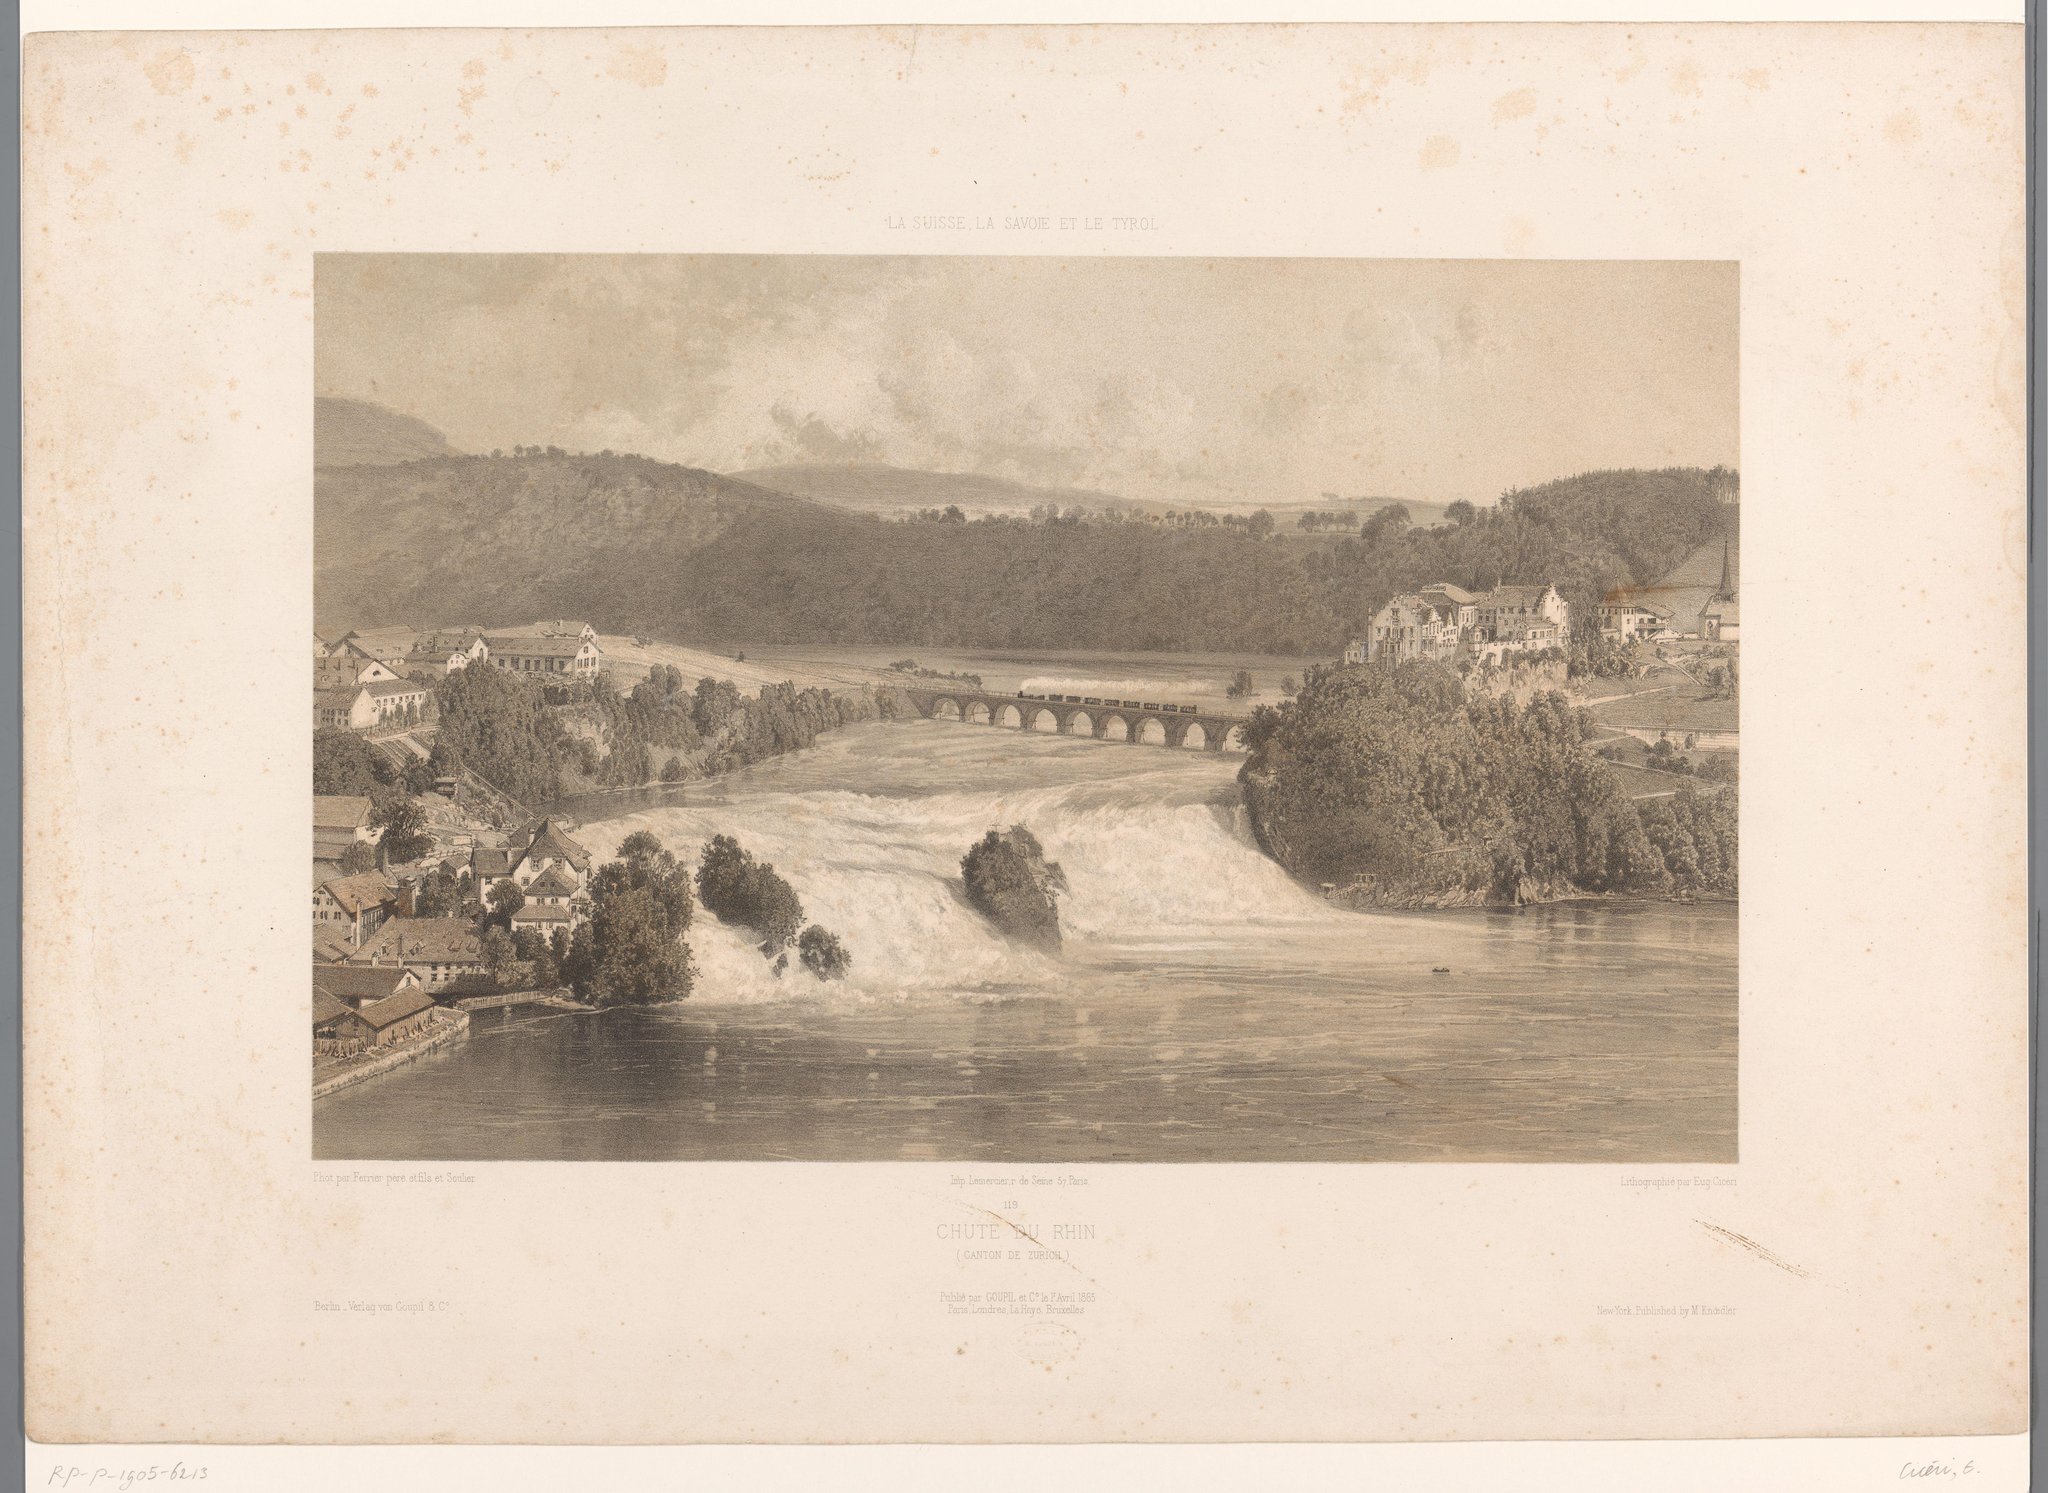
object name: print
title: Gezichten in Zwitserland, Savoye en Tirol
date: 1859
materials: paper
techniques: lithograph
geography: paris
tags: waterfall, landscape with bridge, viaduct or aqueduct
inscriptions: check stamp: Lugt 1090, collector's mark: Lugt 2228a